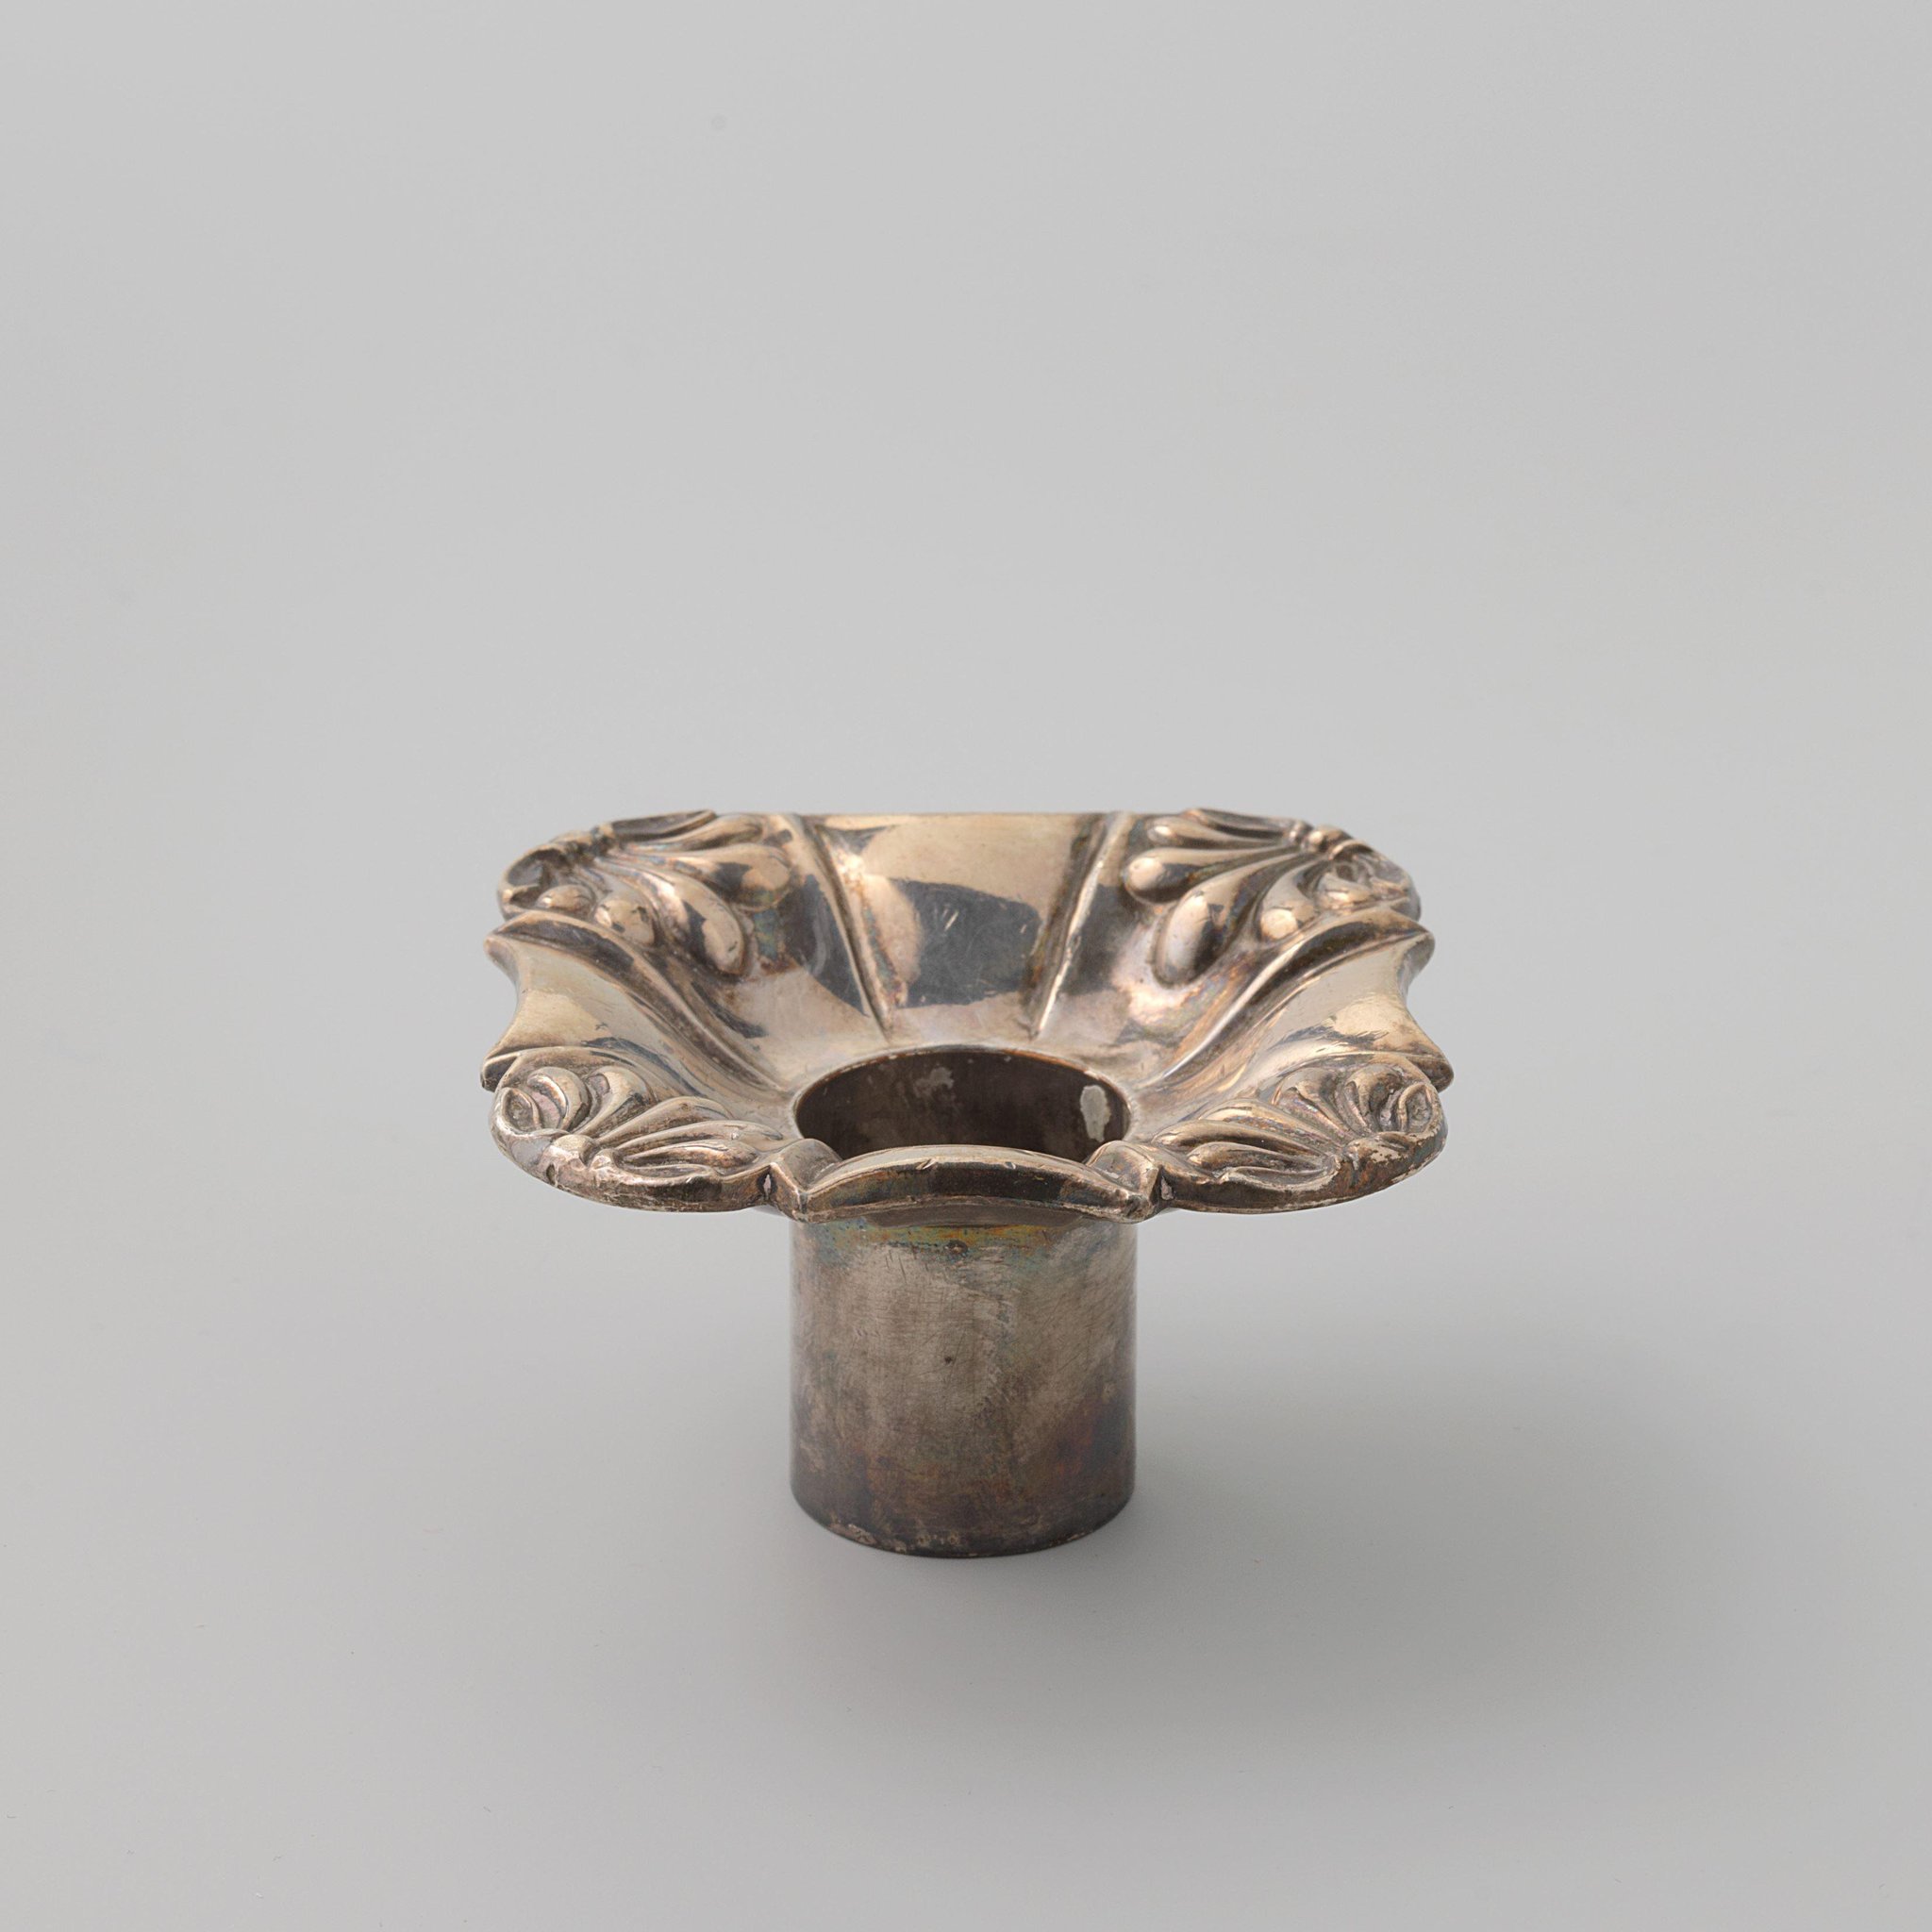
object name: bobeche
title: Vetvanger horend bij een kandelaber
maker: Anonymous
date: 1900-2000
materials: plate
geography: great britain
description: Losse vetvanger horend bij een kandelaber van plate. De vetvanger kan op de vierkante voet worden geplaatst om een kandelaar te vormen.